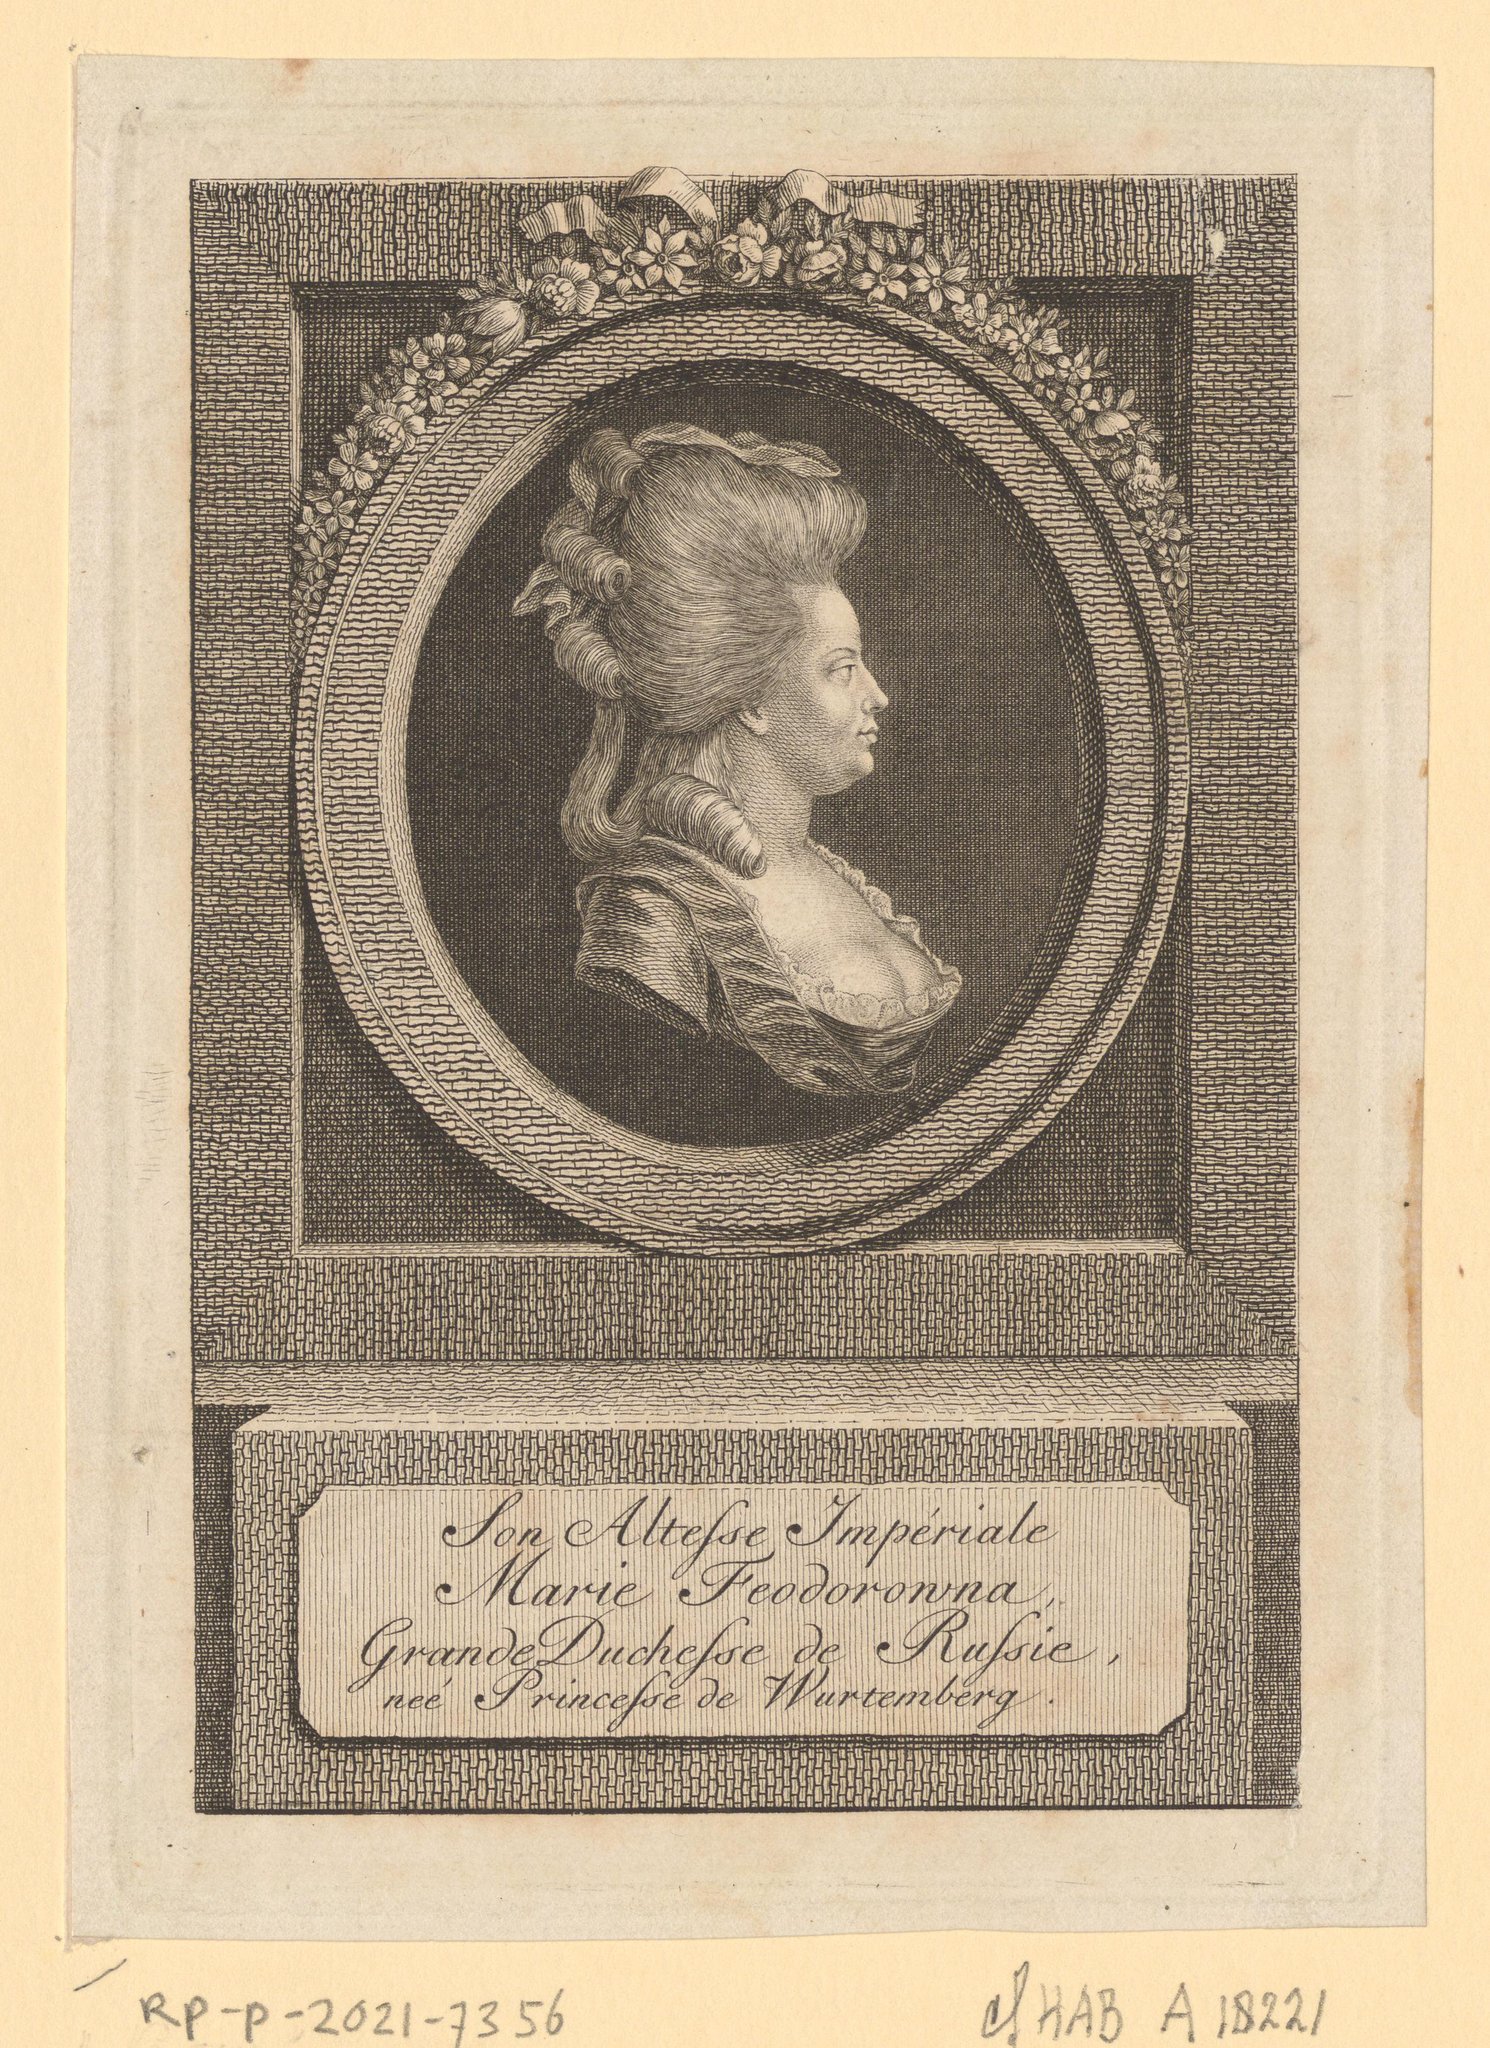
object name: print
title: Portret van Maria Fjodorovna I, keizerin van Rusland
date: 1776-1796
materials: paper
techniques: engraving, etching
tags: poland, maria féodorowna, historical persons - bb - woman, ornament ~ medallion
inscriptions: number: ‘No. 544’